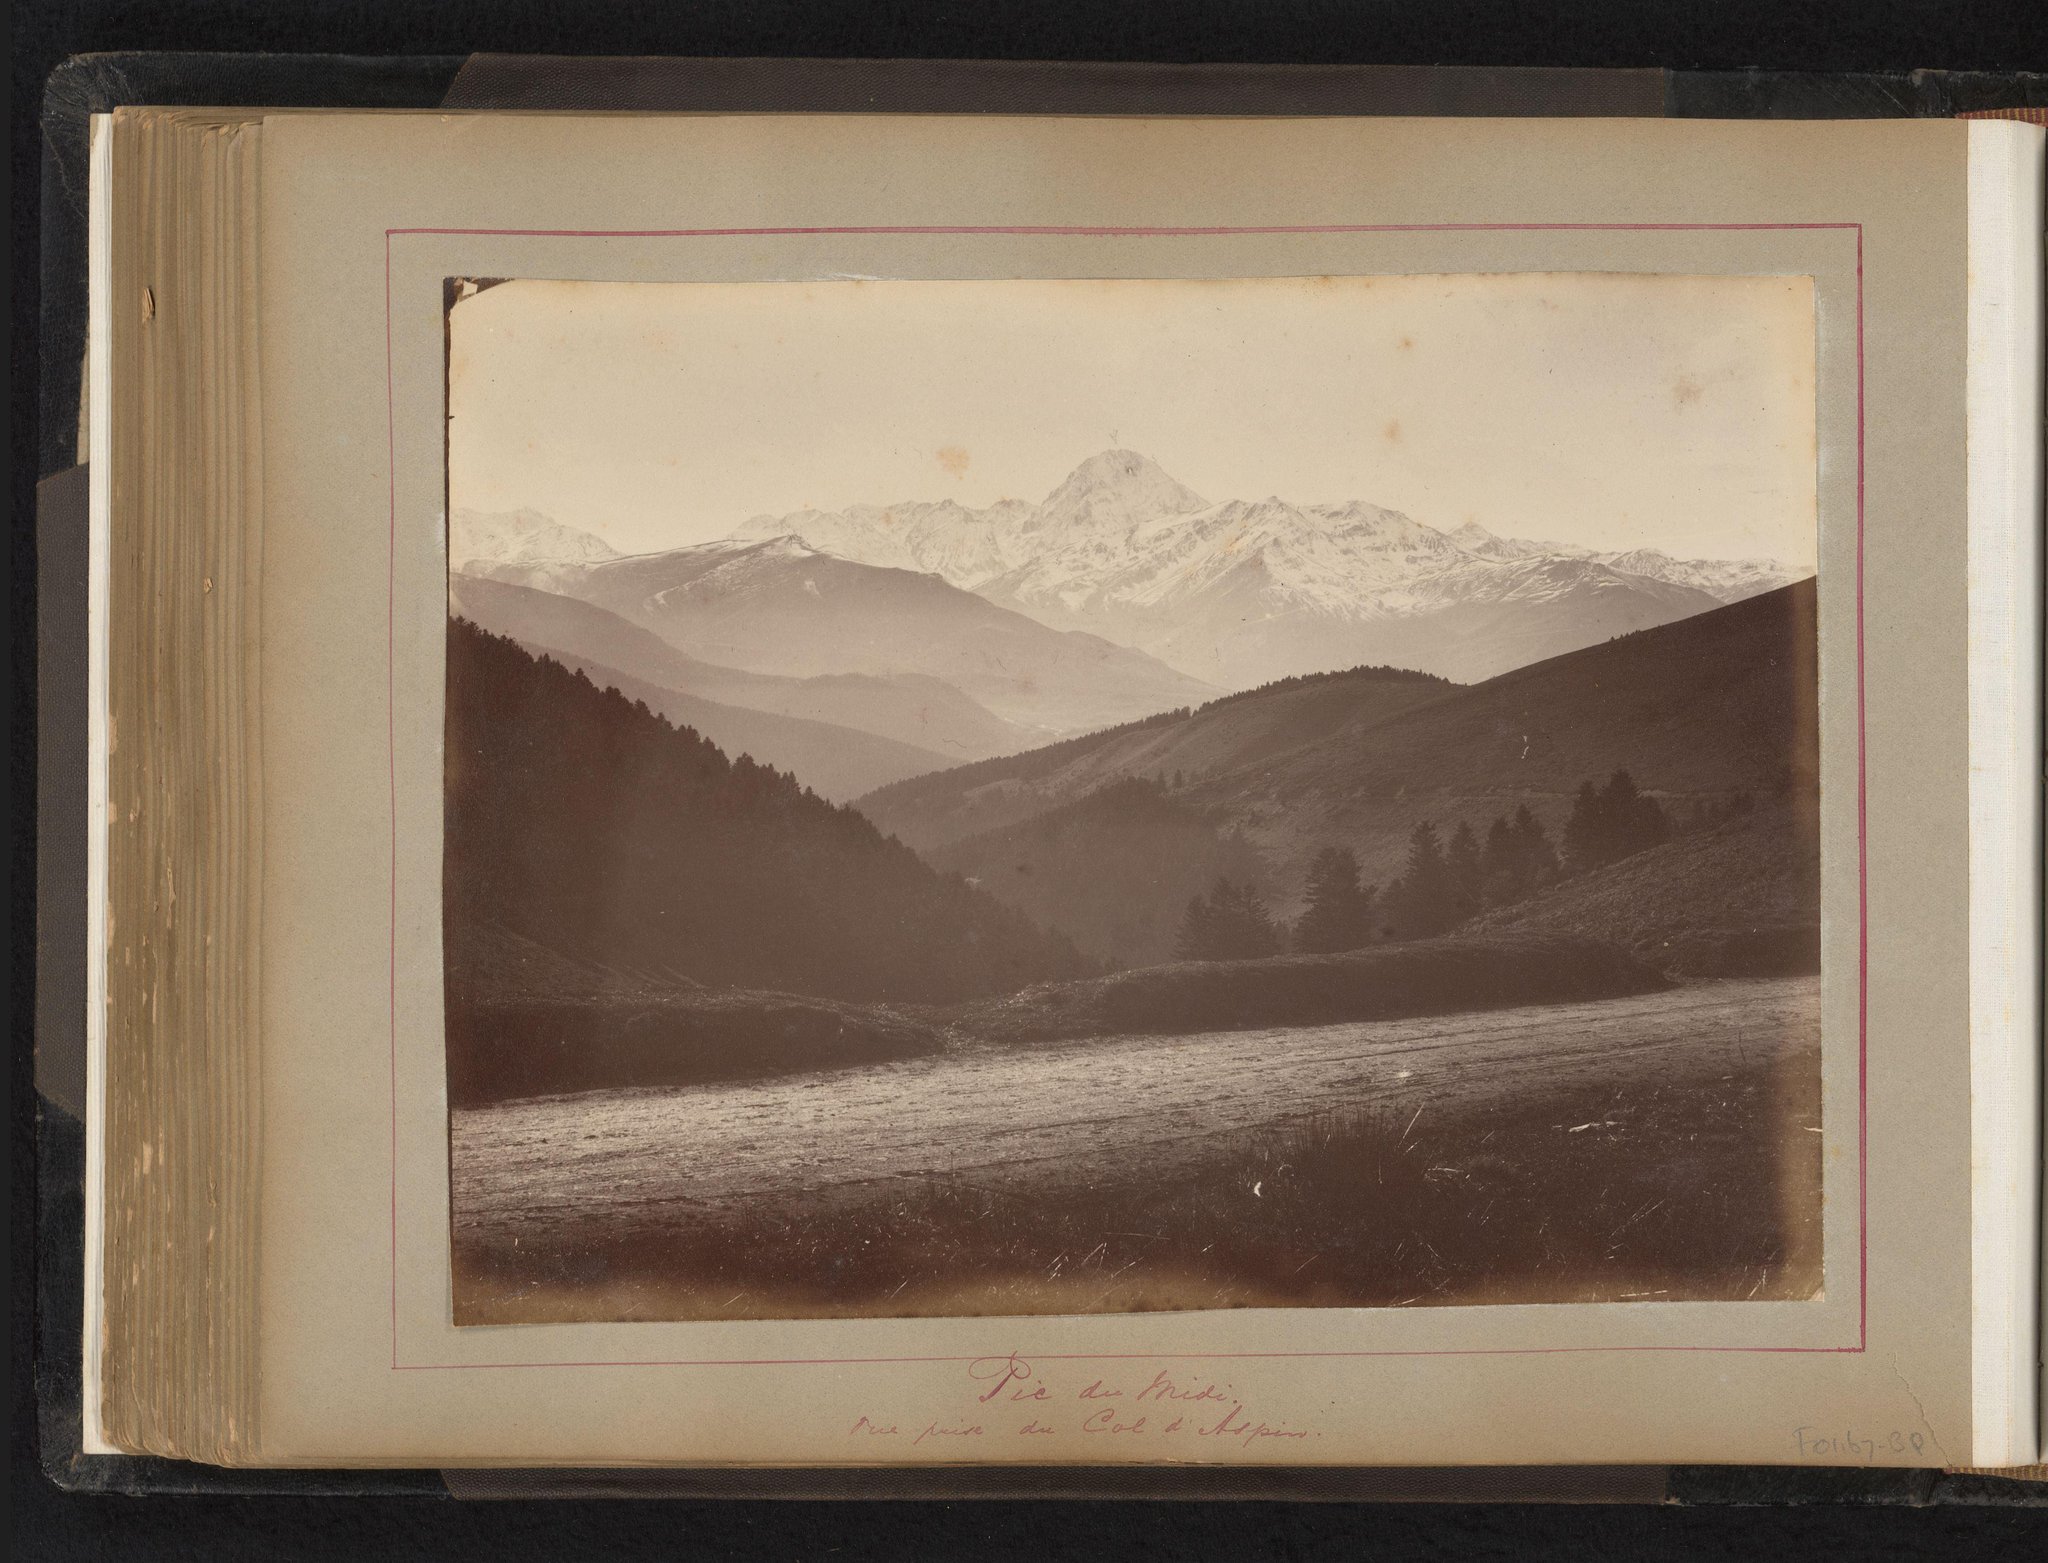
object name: photograph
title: Gezicht op Pic du Midi de Bigorre vanaf de Col d'Aspin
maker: Anonymous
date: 1880-1910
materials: photographic support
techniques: albumen print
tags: mountains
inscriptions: annotation: ‘Pic du Midi/ vue prise de Col d'Aspin’